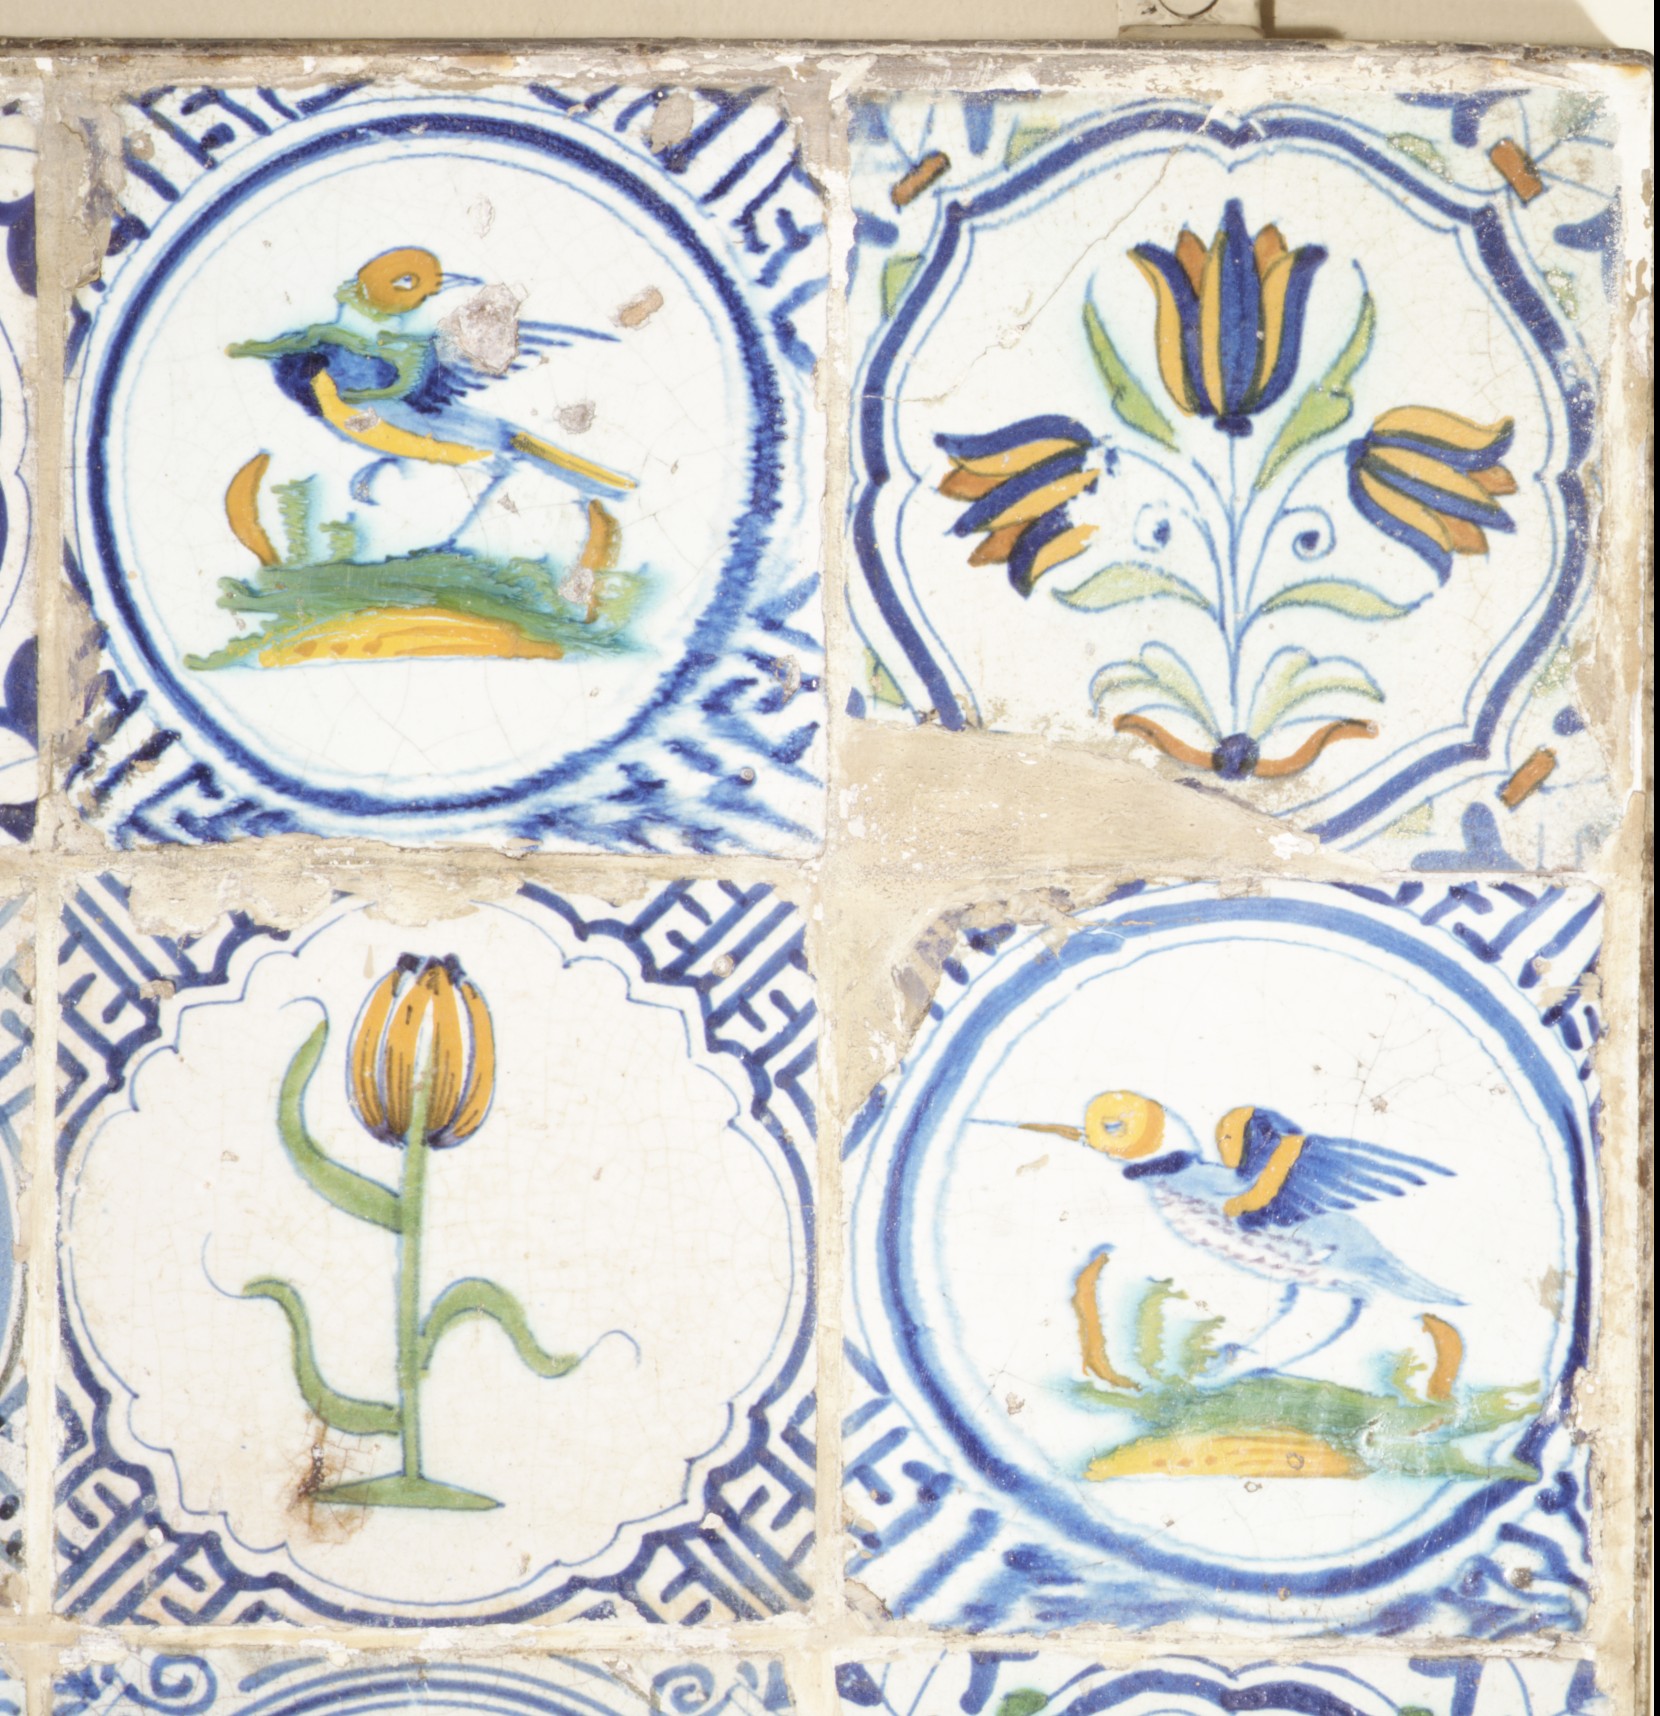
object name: tile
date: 1640-1660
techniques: glazing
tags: birds,flowers